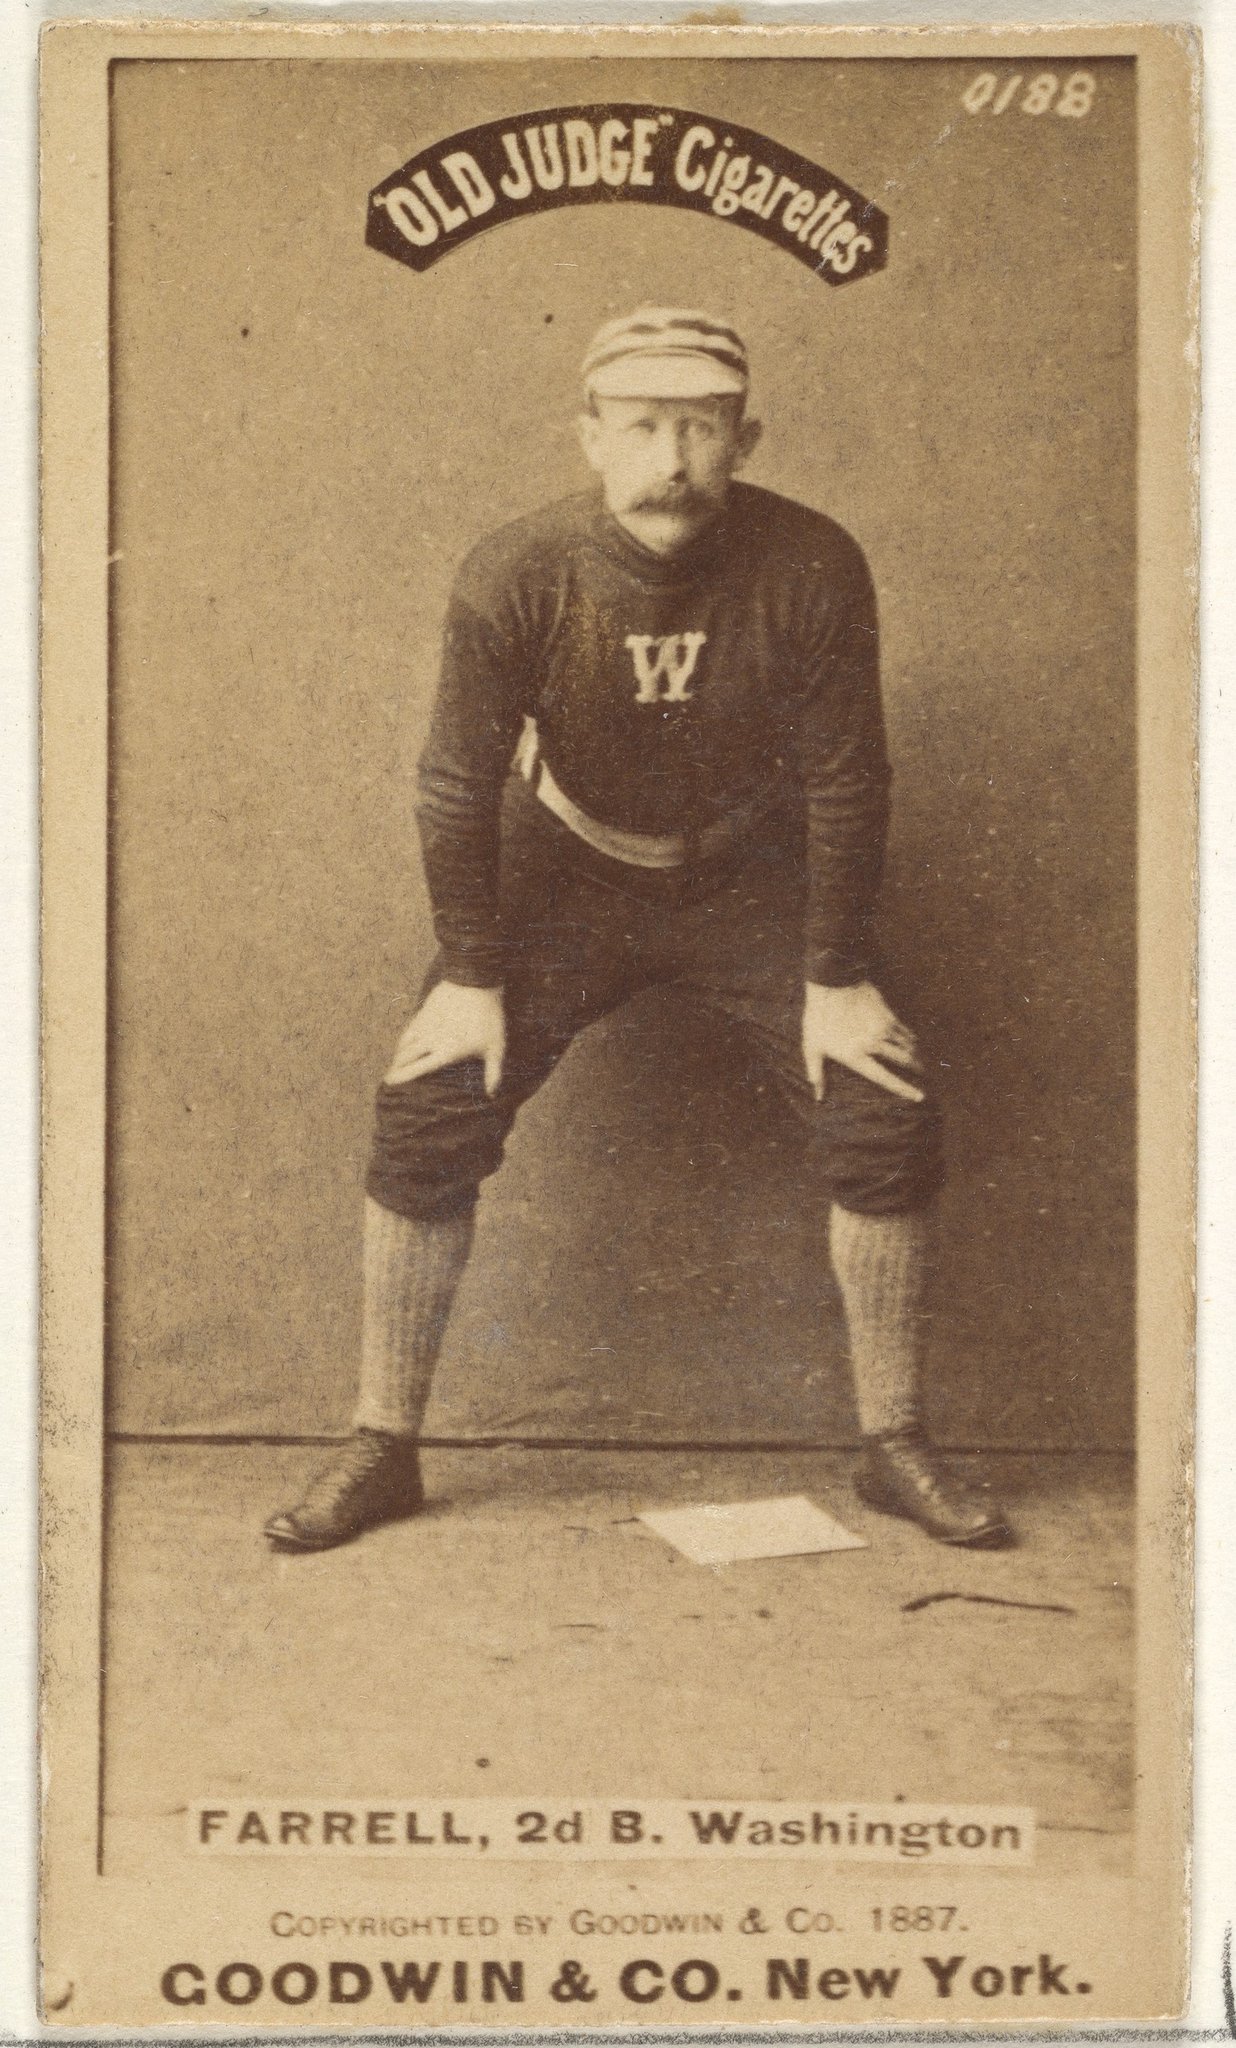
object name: baseball card, photograph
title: John A. "Jack" Farrell, 2nd Base, Washington Nationals, from the Old Judge series (N172) for Old Judge Cigarettes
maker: goodwin & company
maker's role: publisher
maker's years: 1850-1950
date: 1887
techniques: albumen silver print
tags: men,portraits,baseball,athletes